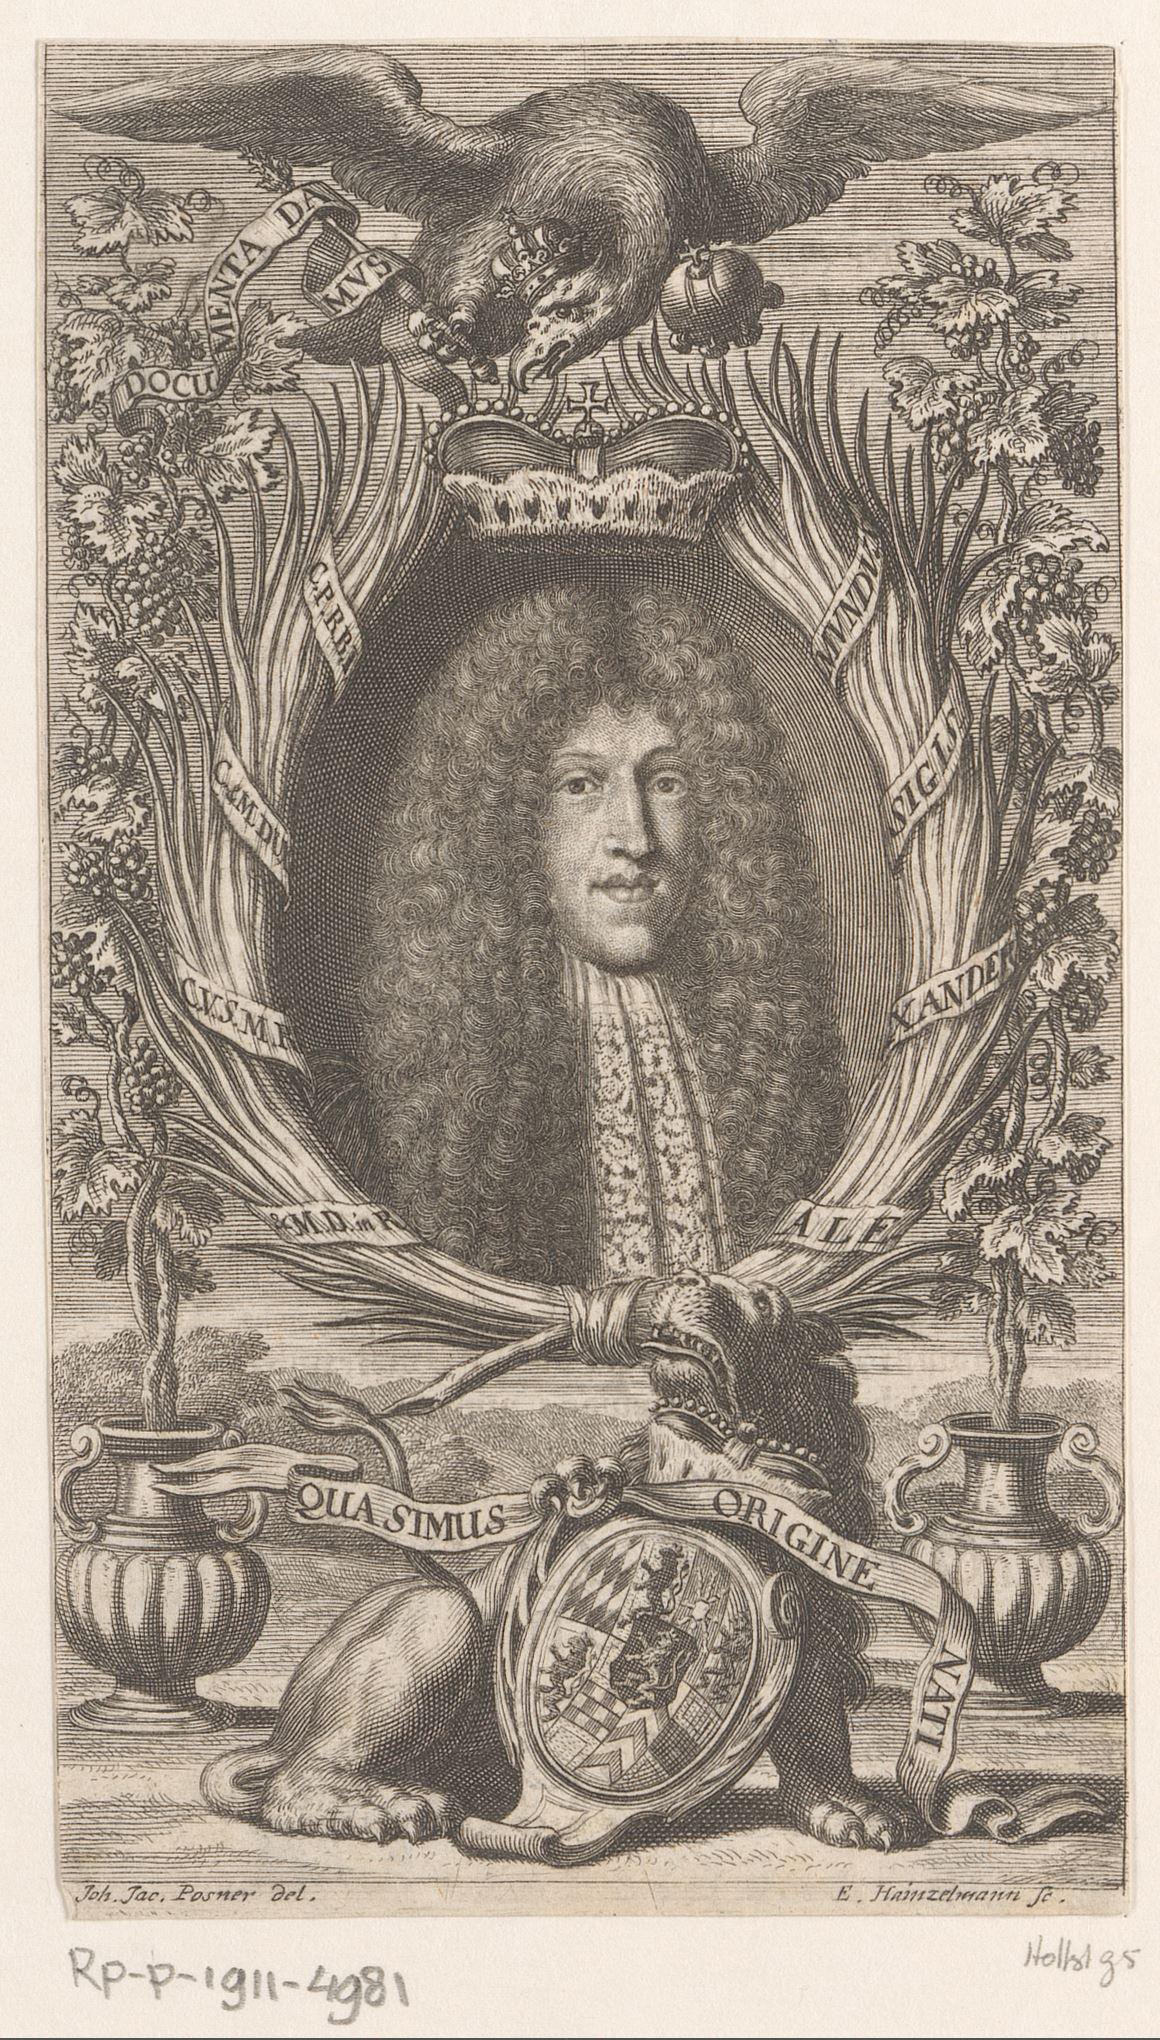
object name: print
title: Portret van Alexander Sigismund von Neuburg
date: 1673-1693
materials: paper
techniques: engraving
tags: augsburg, vine, predatory birds: eagle, historical persons, ruler, sovereign, beasts of prey, predatory animals: lion, armorial bearing, heraldry, insignia and symbols of sovereignty (crown, diadem, sceptre, orb, seal, standard, cloak, pectoral)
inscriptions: collector's mark: Lugt 2228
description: De in boekdruk gedrukte teksten van andere pagina's hebben afgegeven op de achterzijde van deze prent.